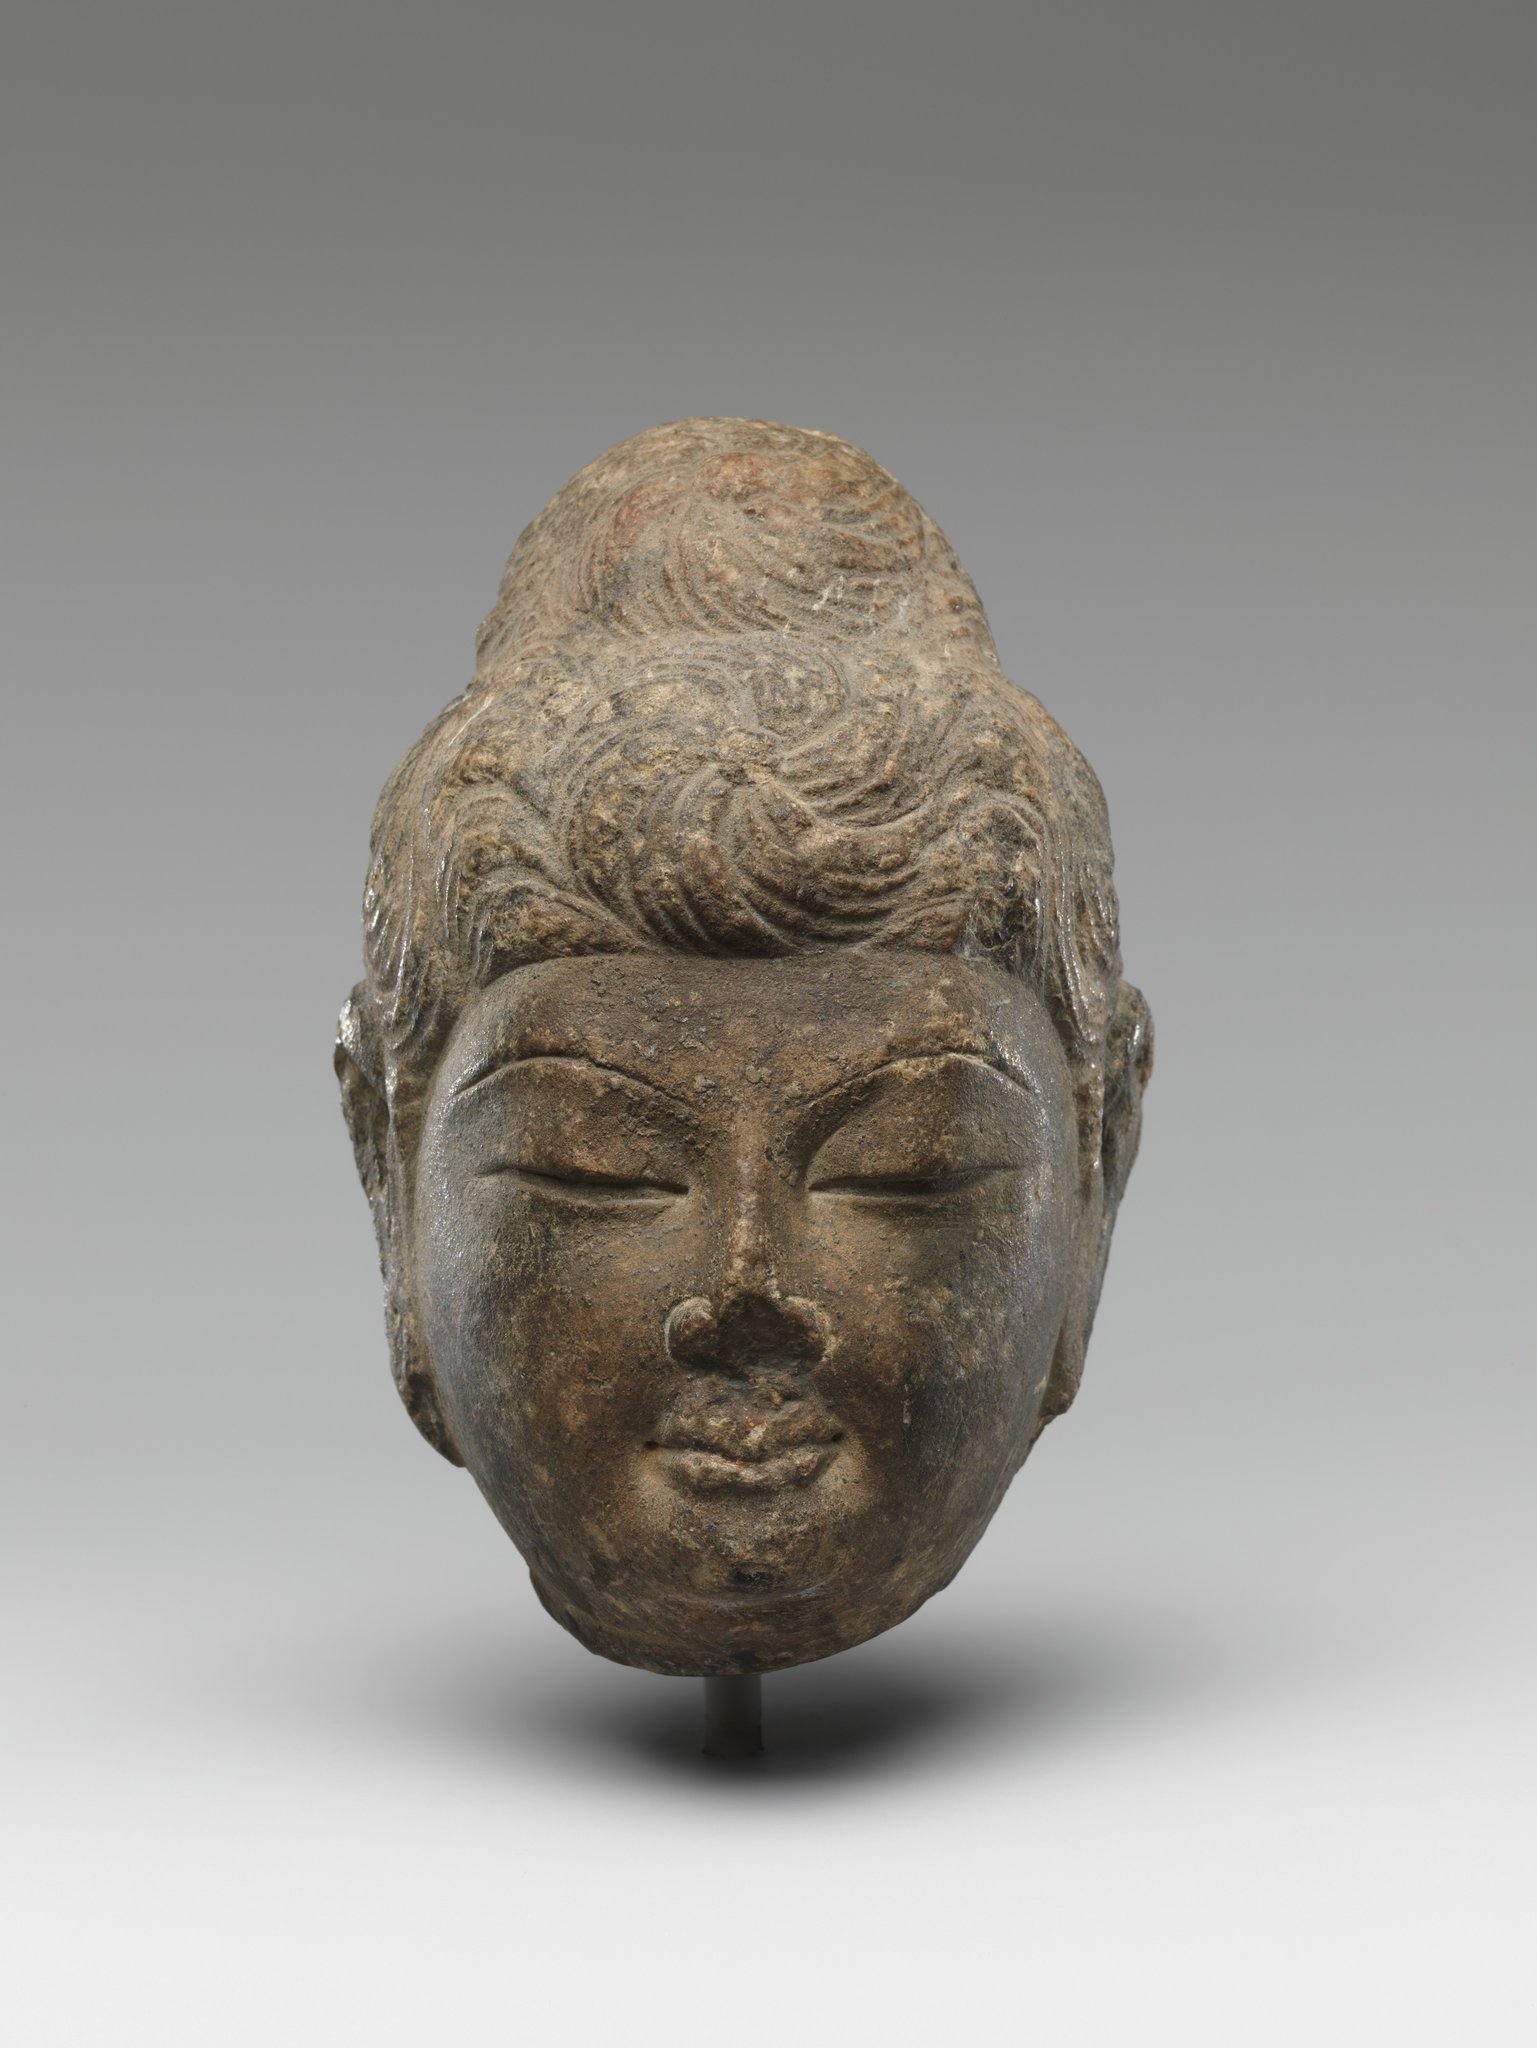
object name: head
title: Head of Buddha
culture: chinese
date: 734-766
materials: limestone, pigment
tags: heads,buddha